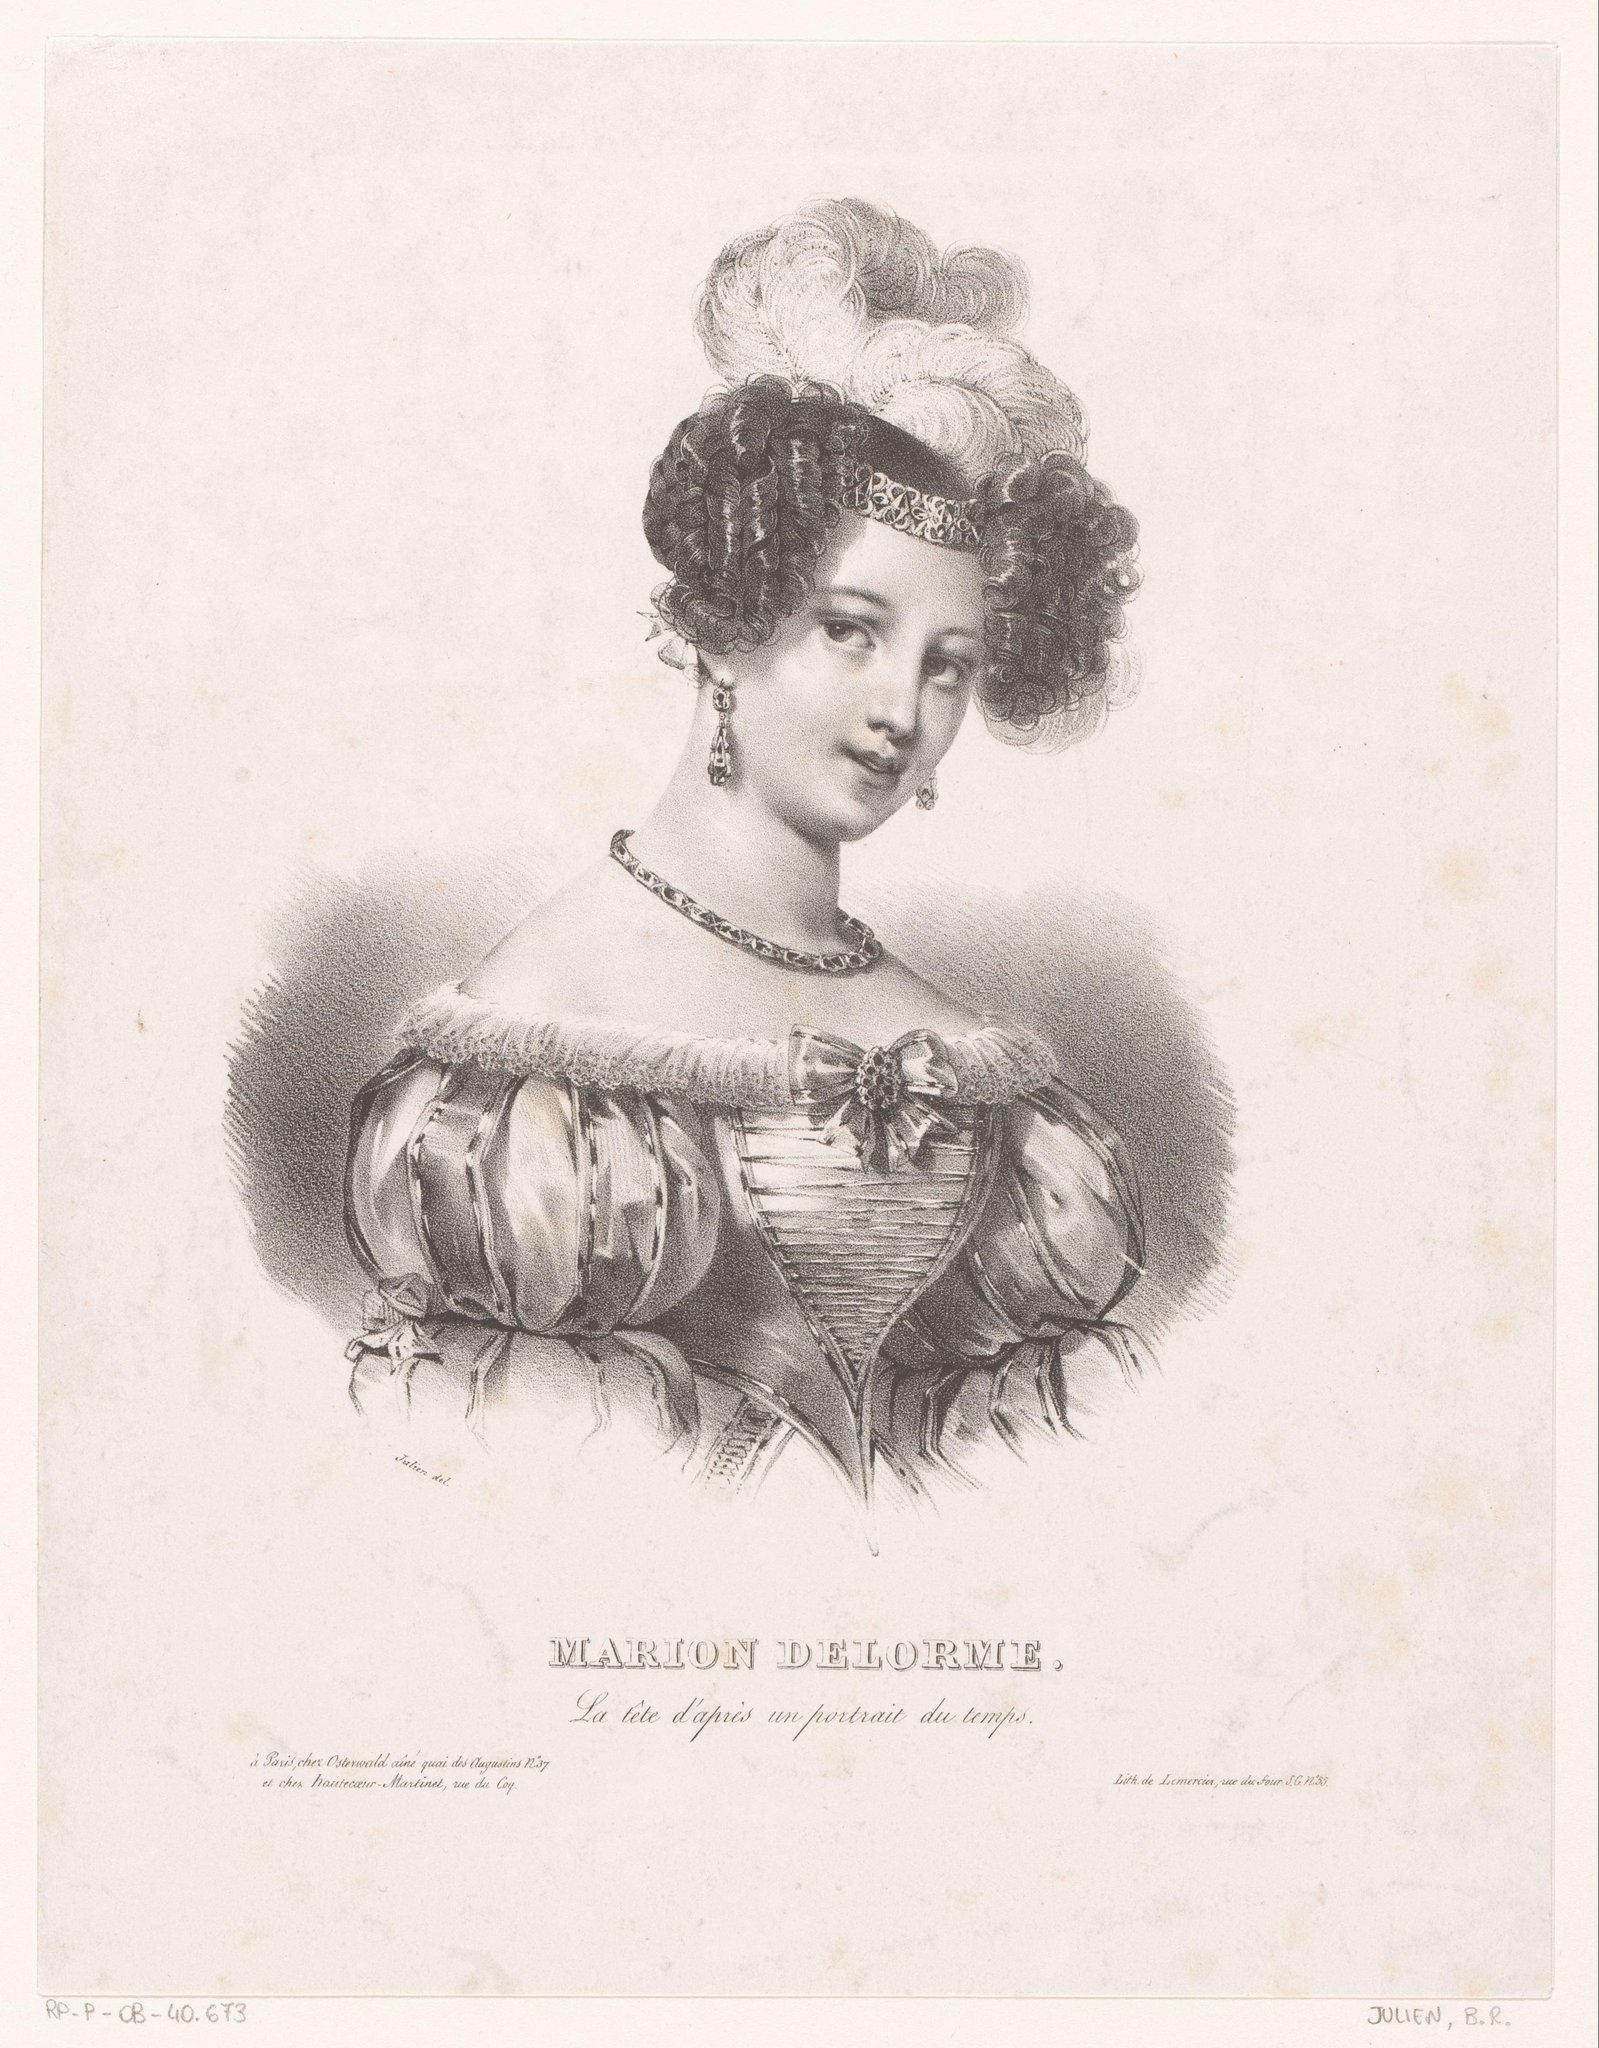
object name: print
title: Marion Delorme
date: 1832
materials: paper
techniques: lithograph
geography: paris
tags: paris, historical persons